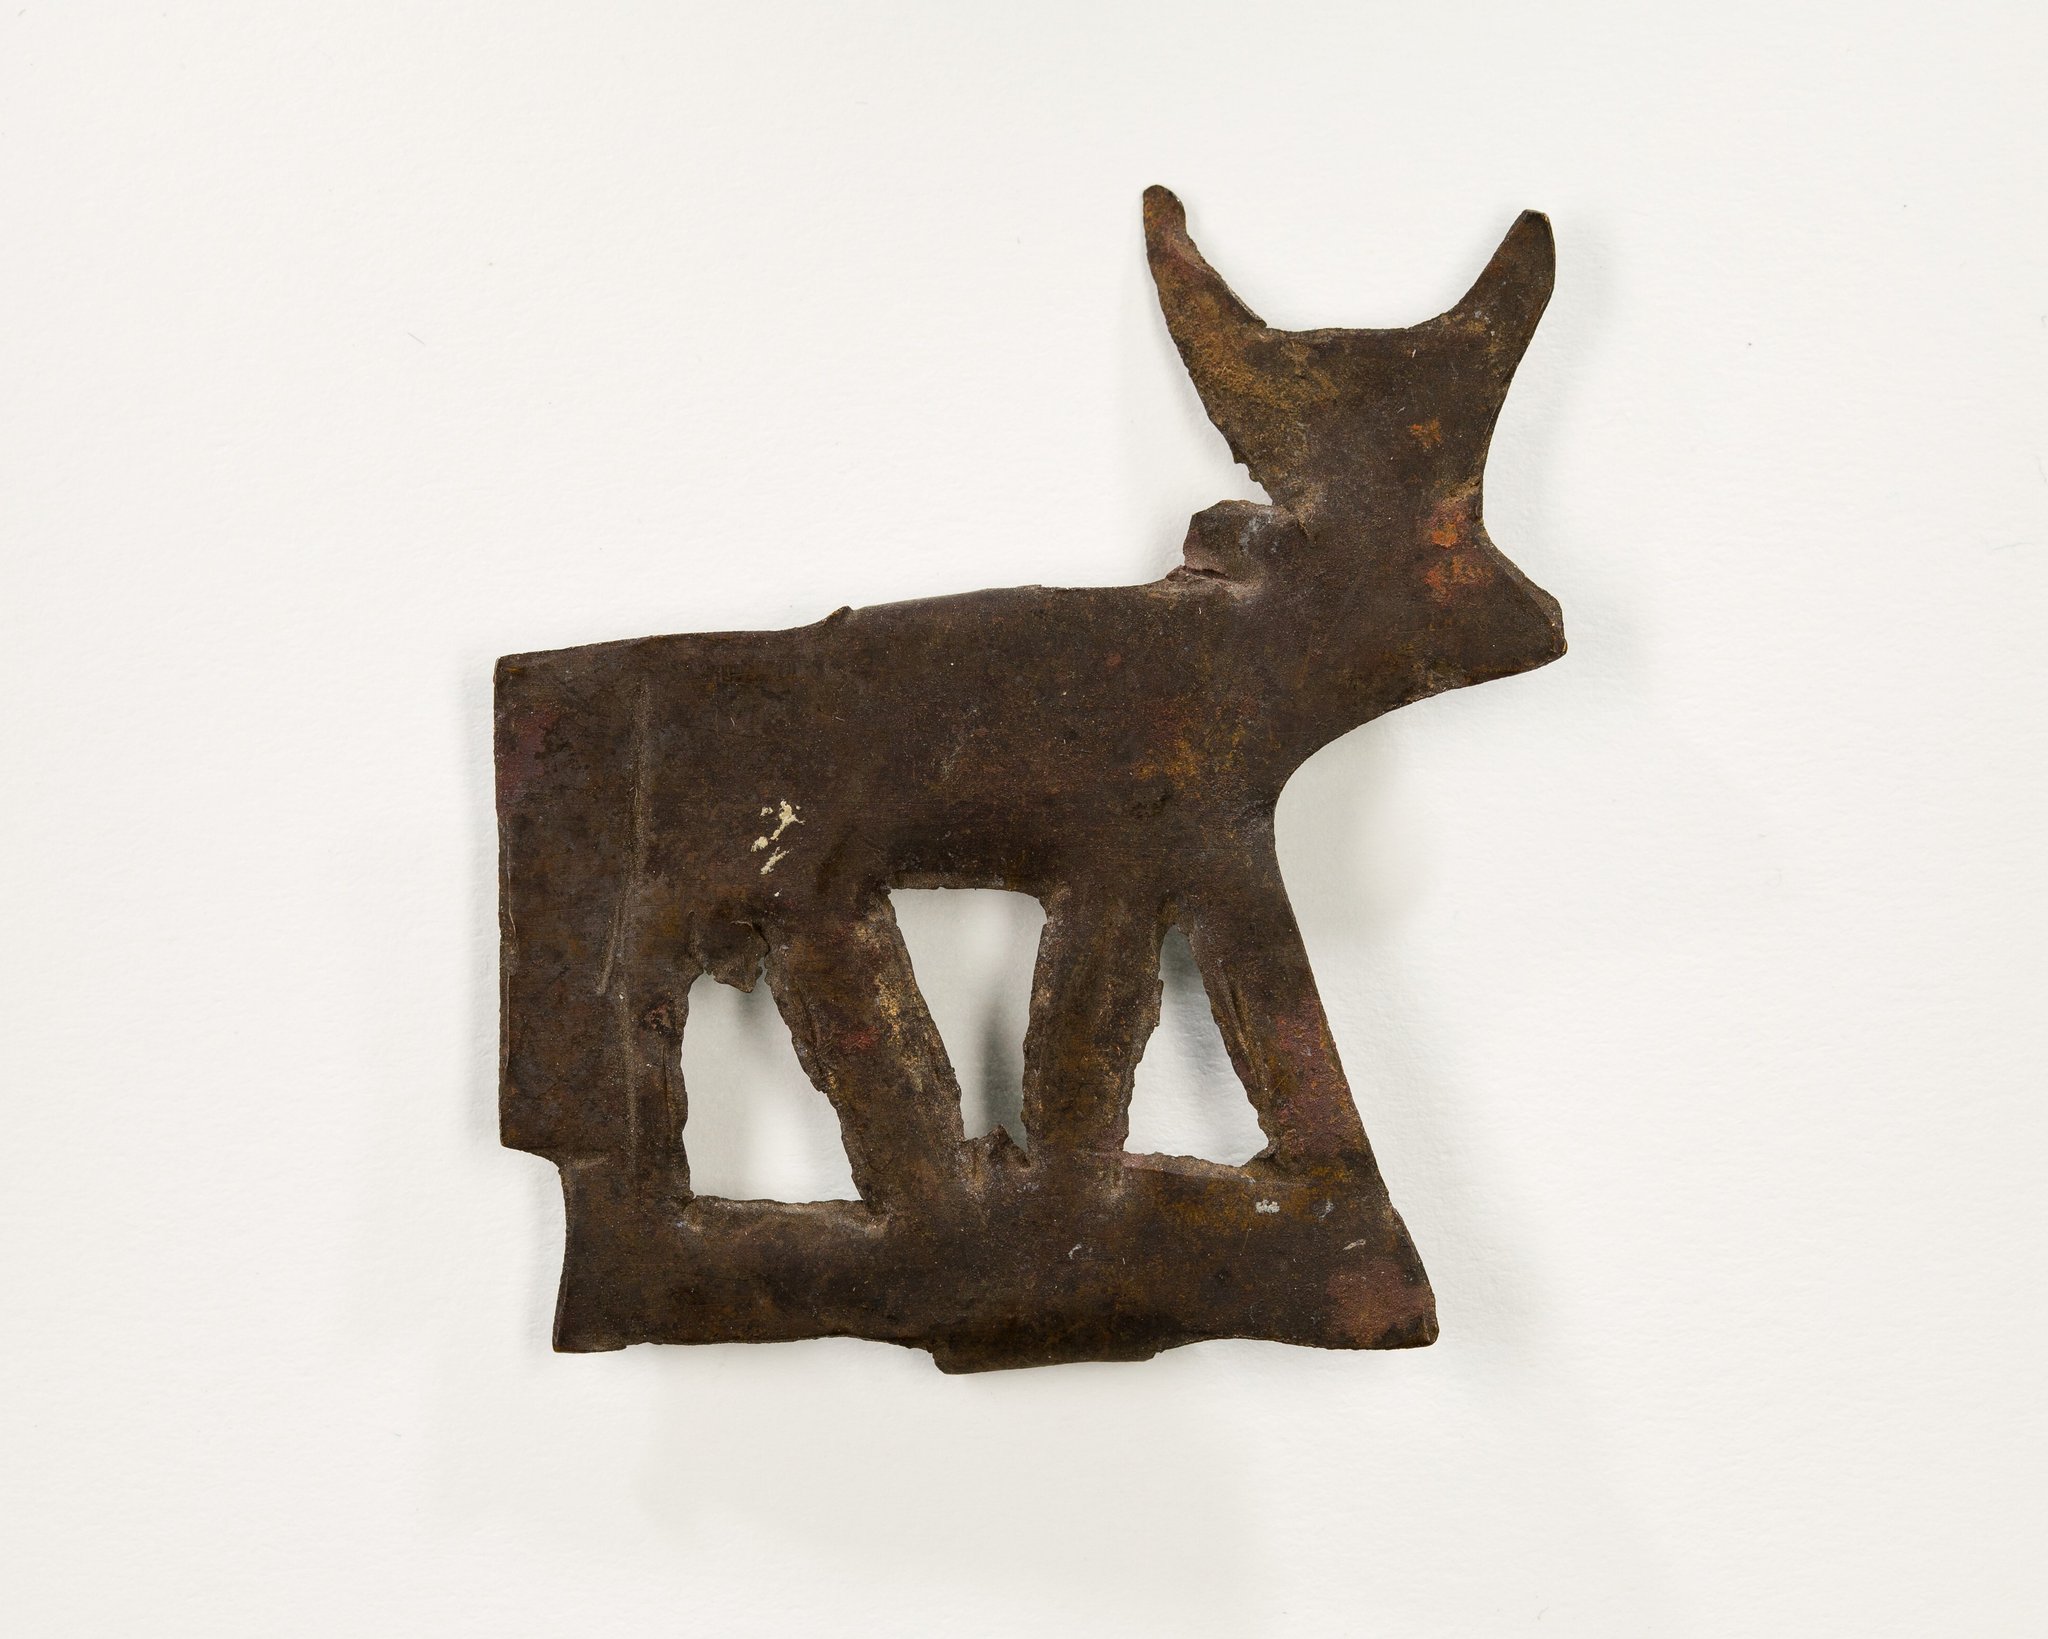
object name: votive, plaque, cow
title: Cow plaque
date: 1479-1458 BCE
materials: bronze, copper alloy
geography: egypt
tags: cows